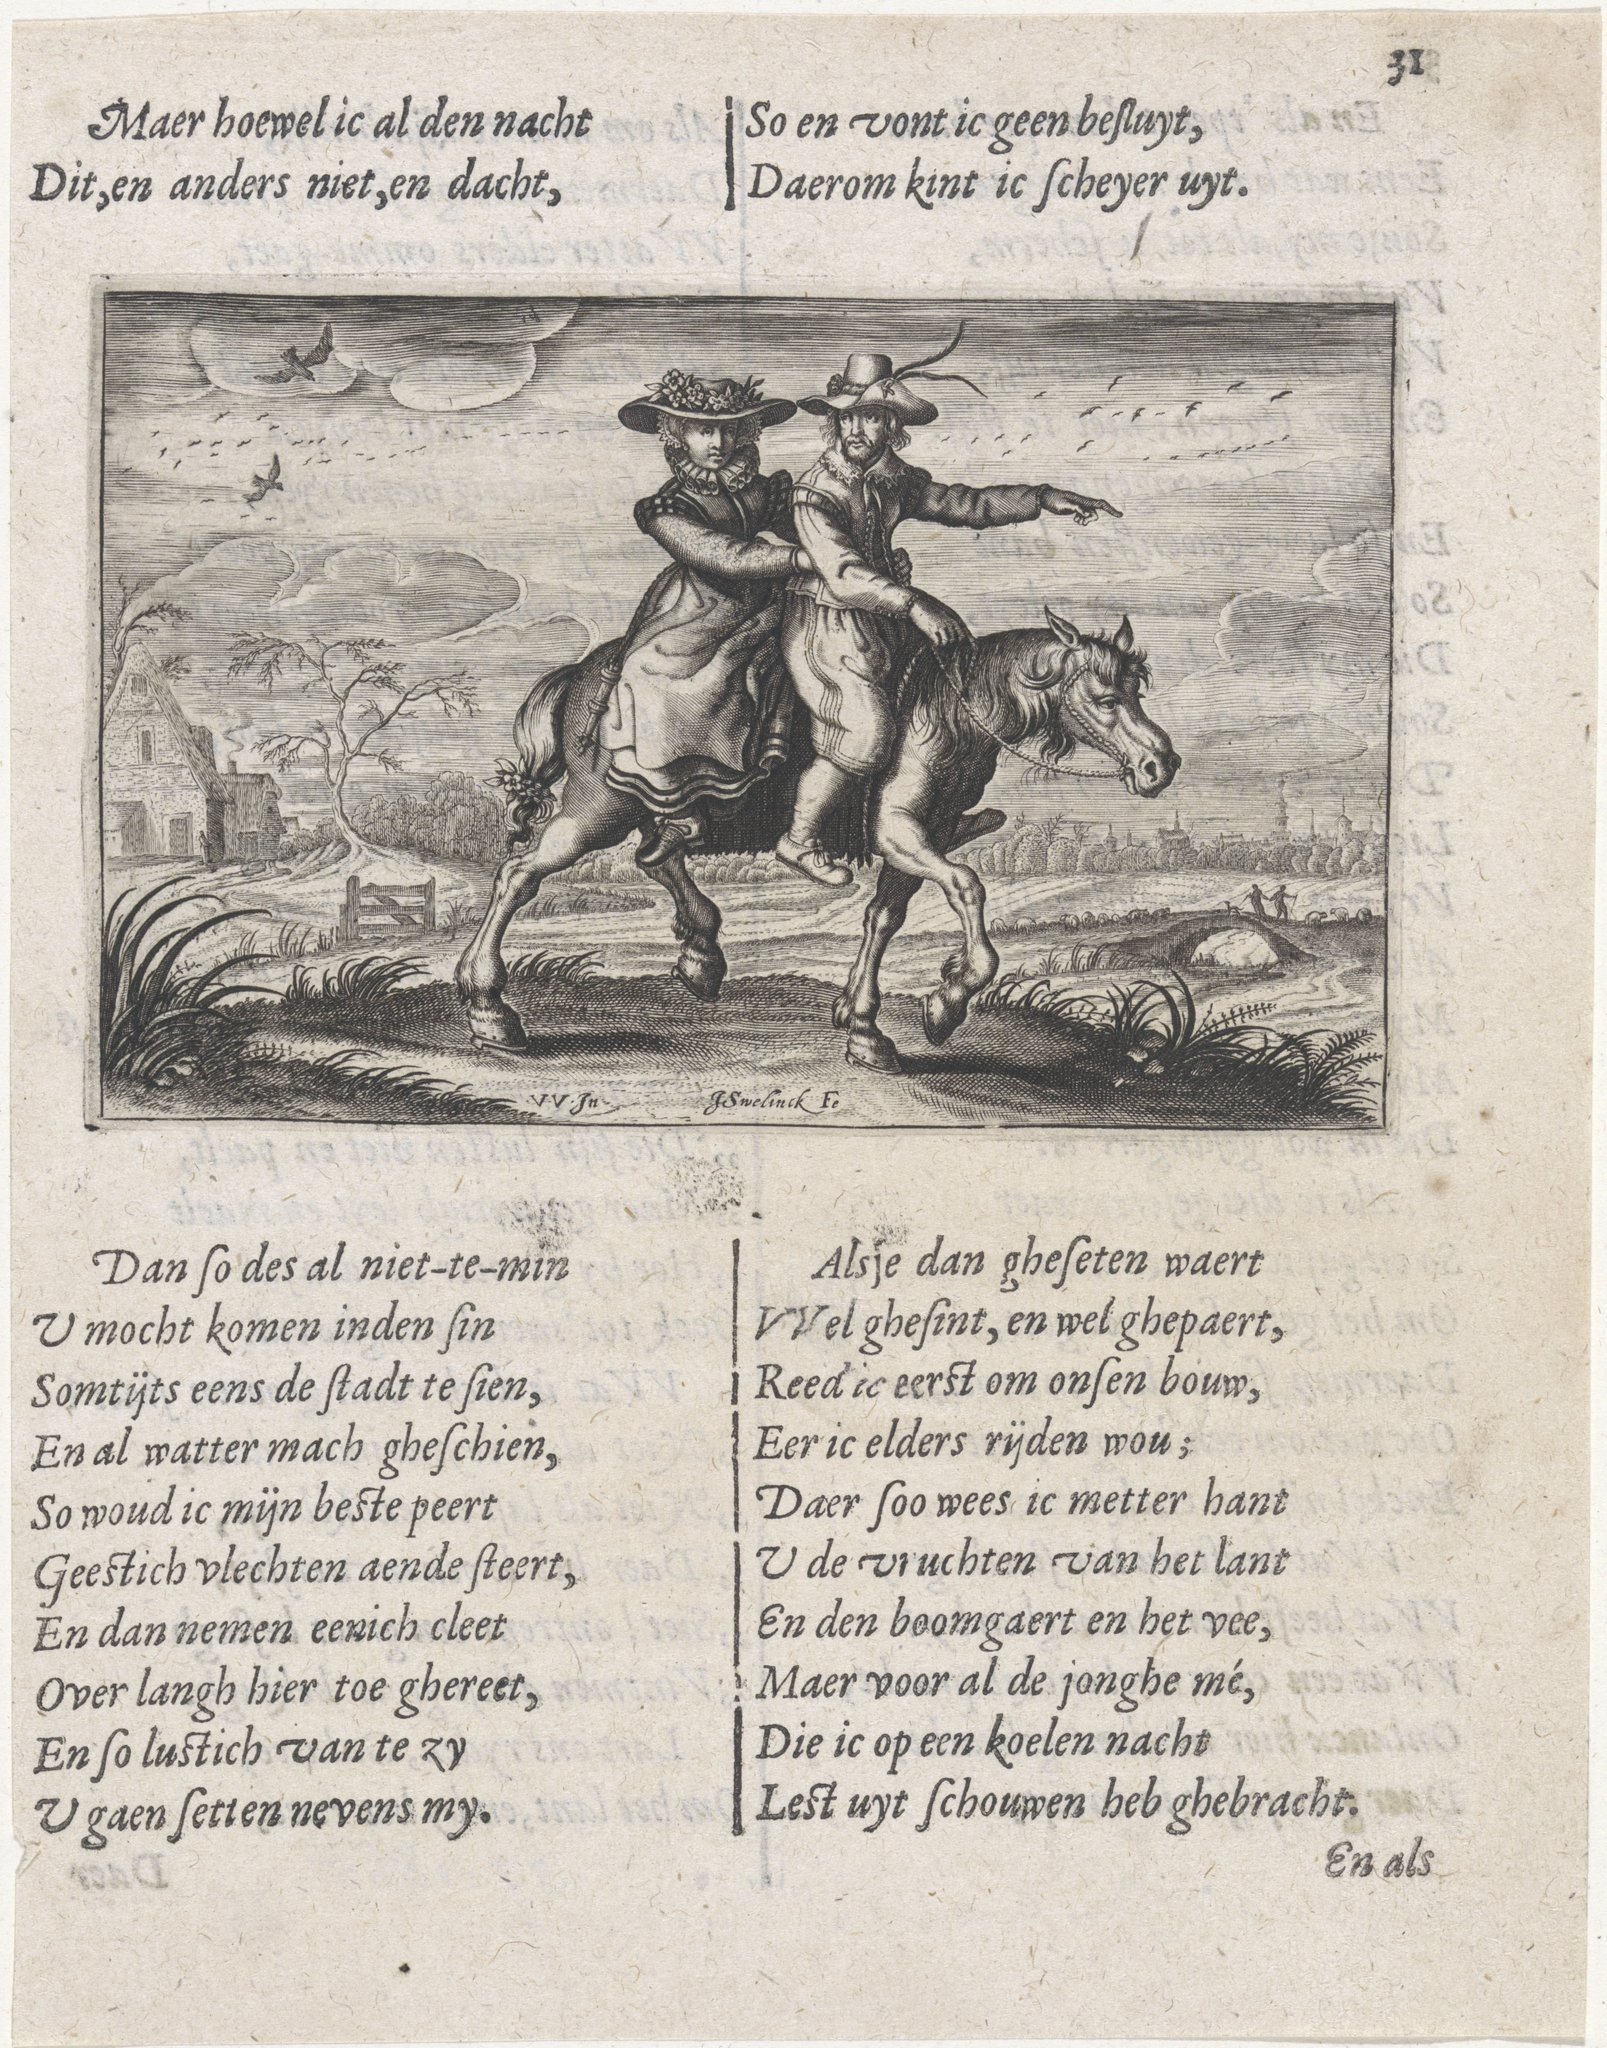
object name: print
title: Man en vrouw te paard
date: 1624-1645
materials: paper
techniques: engraving, letterpress printing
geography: amsterdam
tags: riding a horse, ass, or mule; rider, horseman, horse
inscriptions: collector's mark: Lugt 2228, collector's mark: Lugt 2760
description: Een man en vrouw zitten samen op een paard, dat over een landweggetje loopt. De staart van het paard is met bloemen versierd. Op de achtergrond een stad. Onder en boven de prent versregels in het Nederlands.